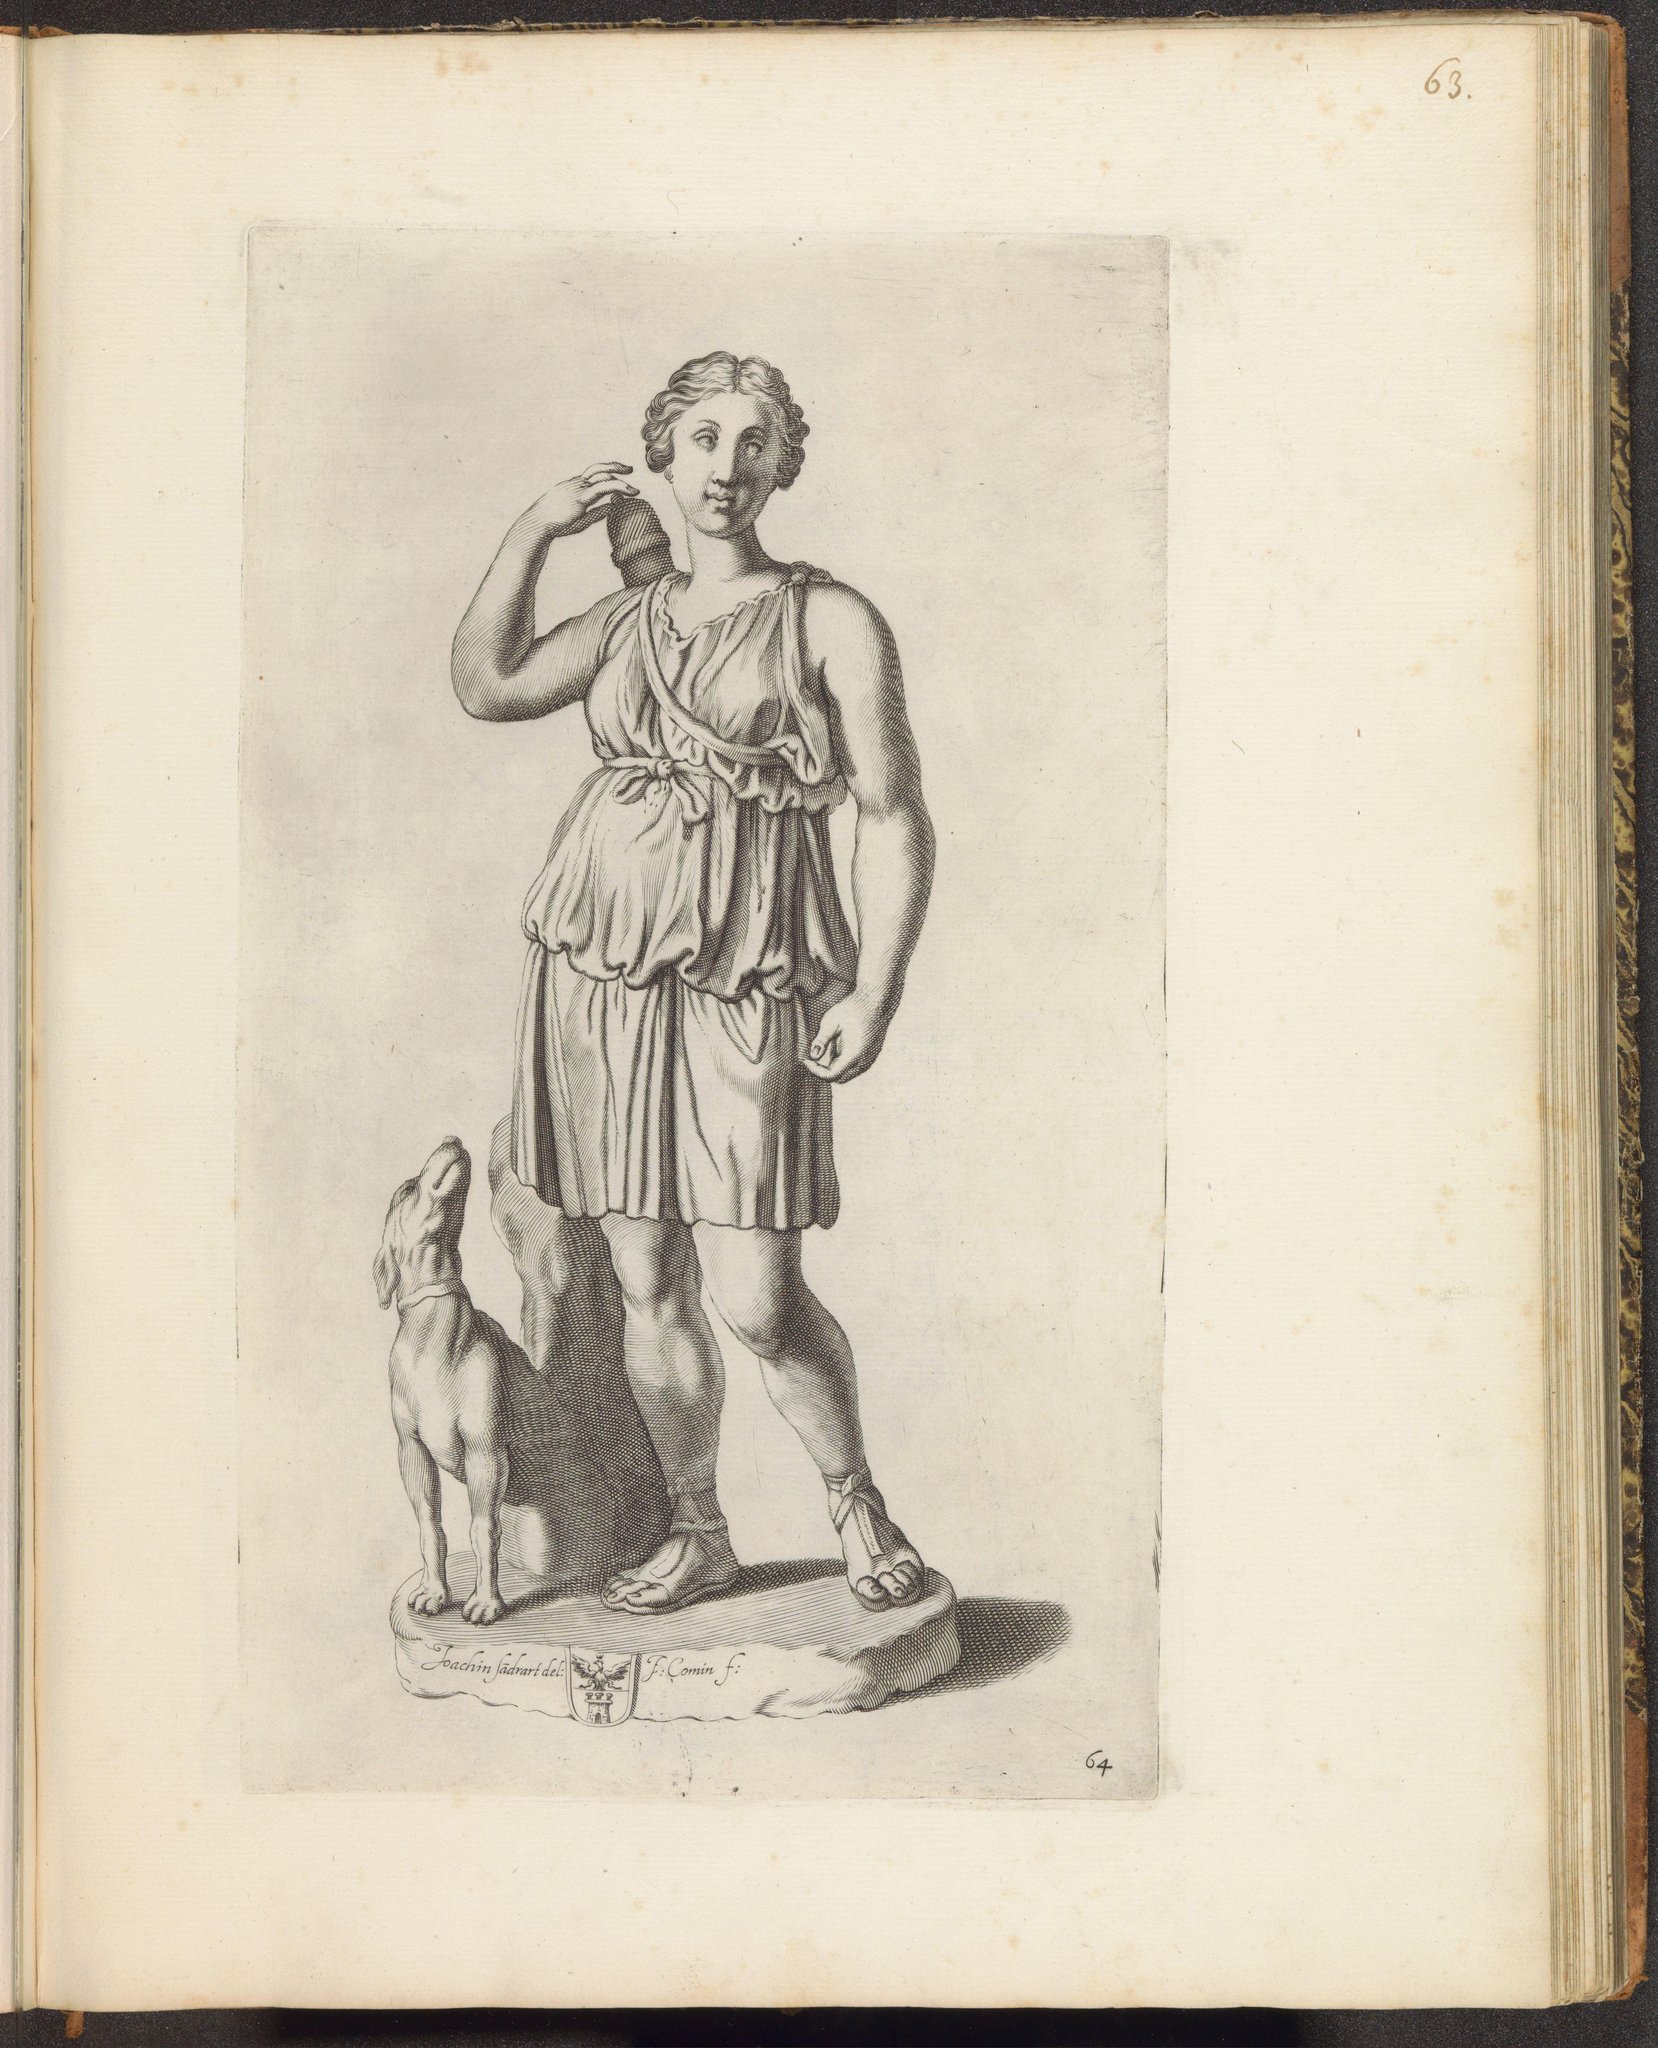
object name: album leaf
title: Standbeeld van Diana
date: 1636-1647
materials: paper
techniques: engraving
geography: rome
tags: (story of) diana (artemis), piece of sculpture, reproduction of a piece of sculpture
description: Standbeeld van Diana, de godin van de jacht, gekleed in klassiek gewaad tot op de knie. Ze pakt een pijl uit de pijlenkoker op haar rug. Naast haar een hond die naar haar opkijkt. Op de basis het wapenschild van Vincenzo Giustiniani. Prent maakt deel uit van een album met een serie prenten naar de sculpturen in de verzameling in de Galleria Giustiniani te Rome.